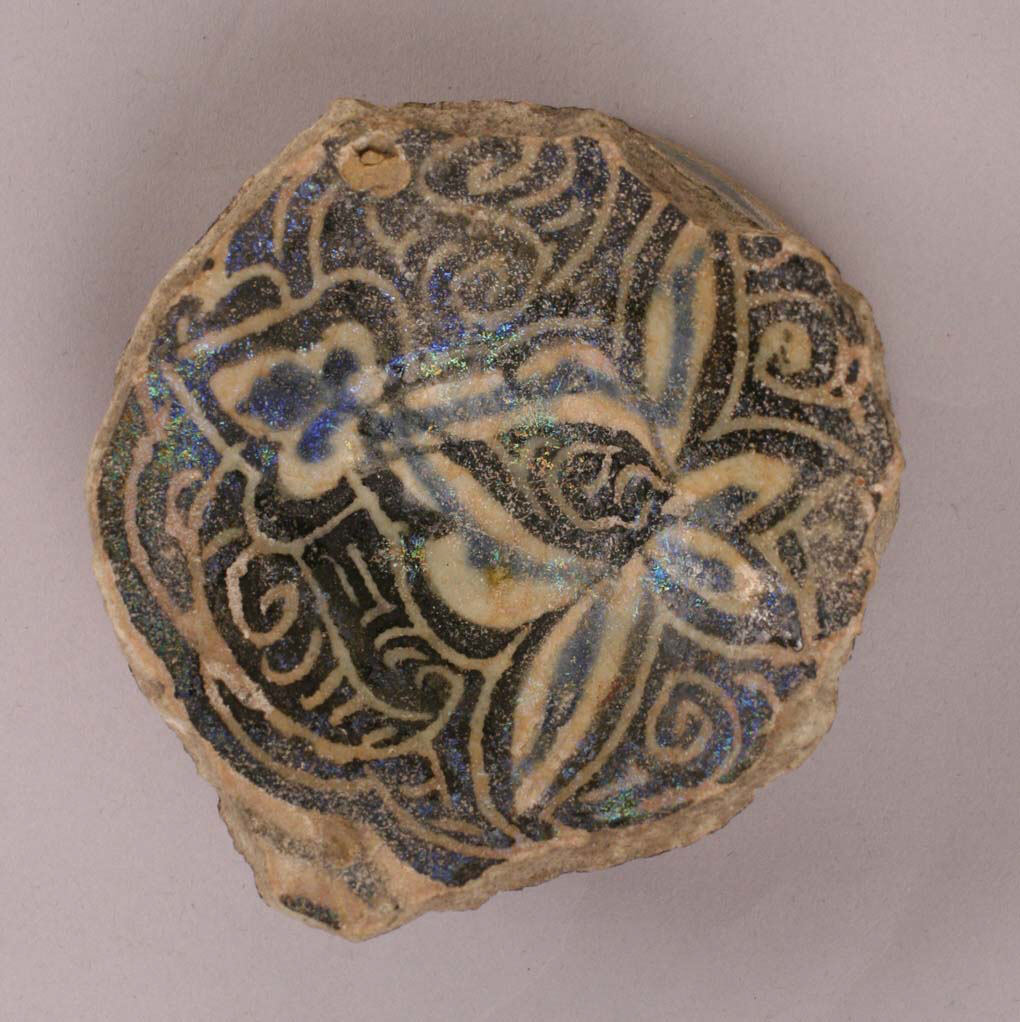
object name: fragment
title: Ceramic Fragment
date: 1201-1600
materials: glaze, stonepaste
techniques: painting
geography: egypt